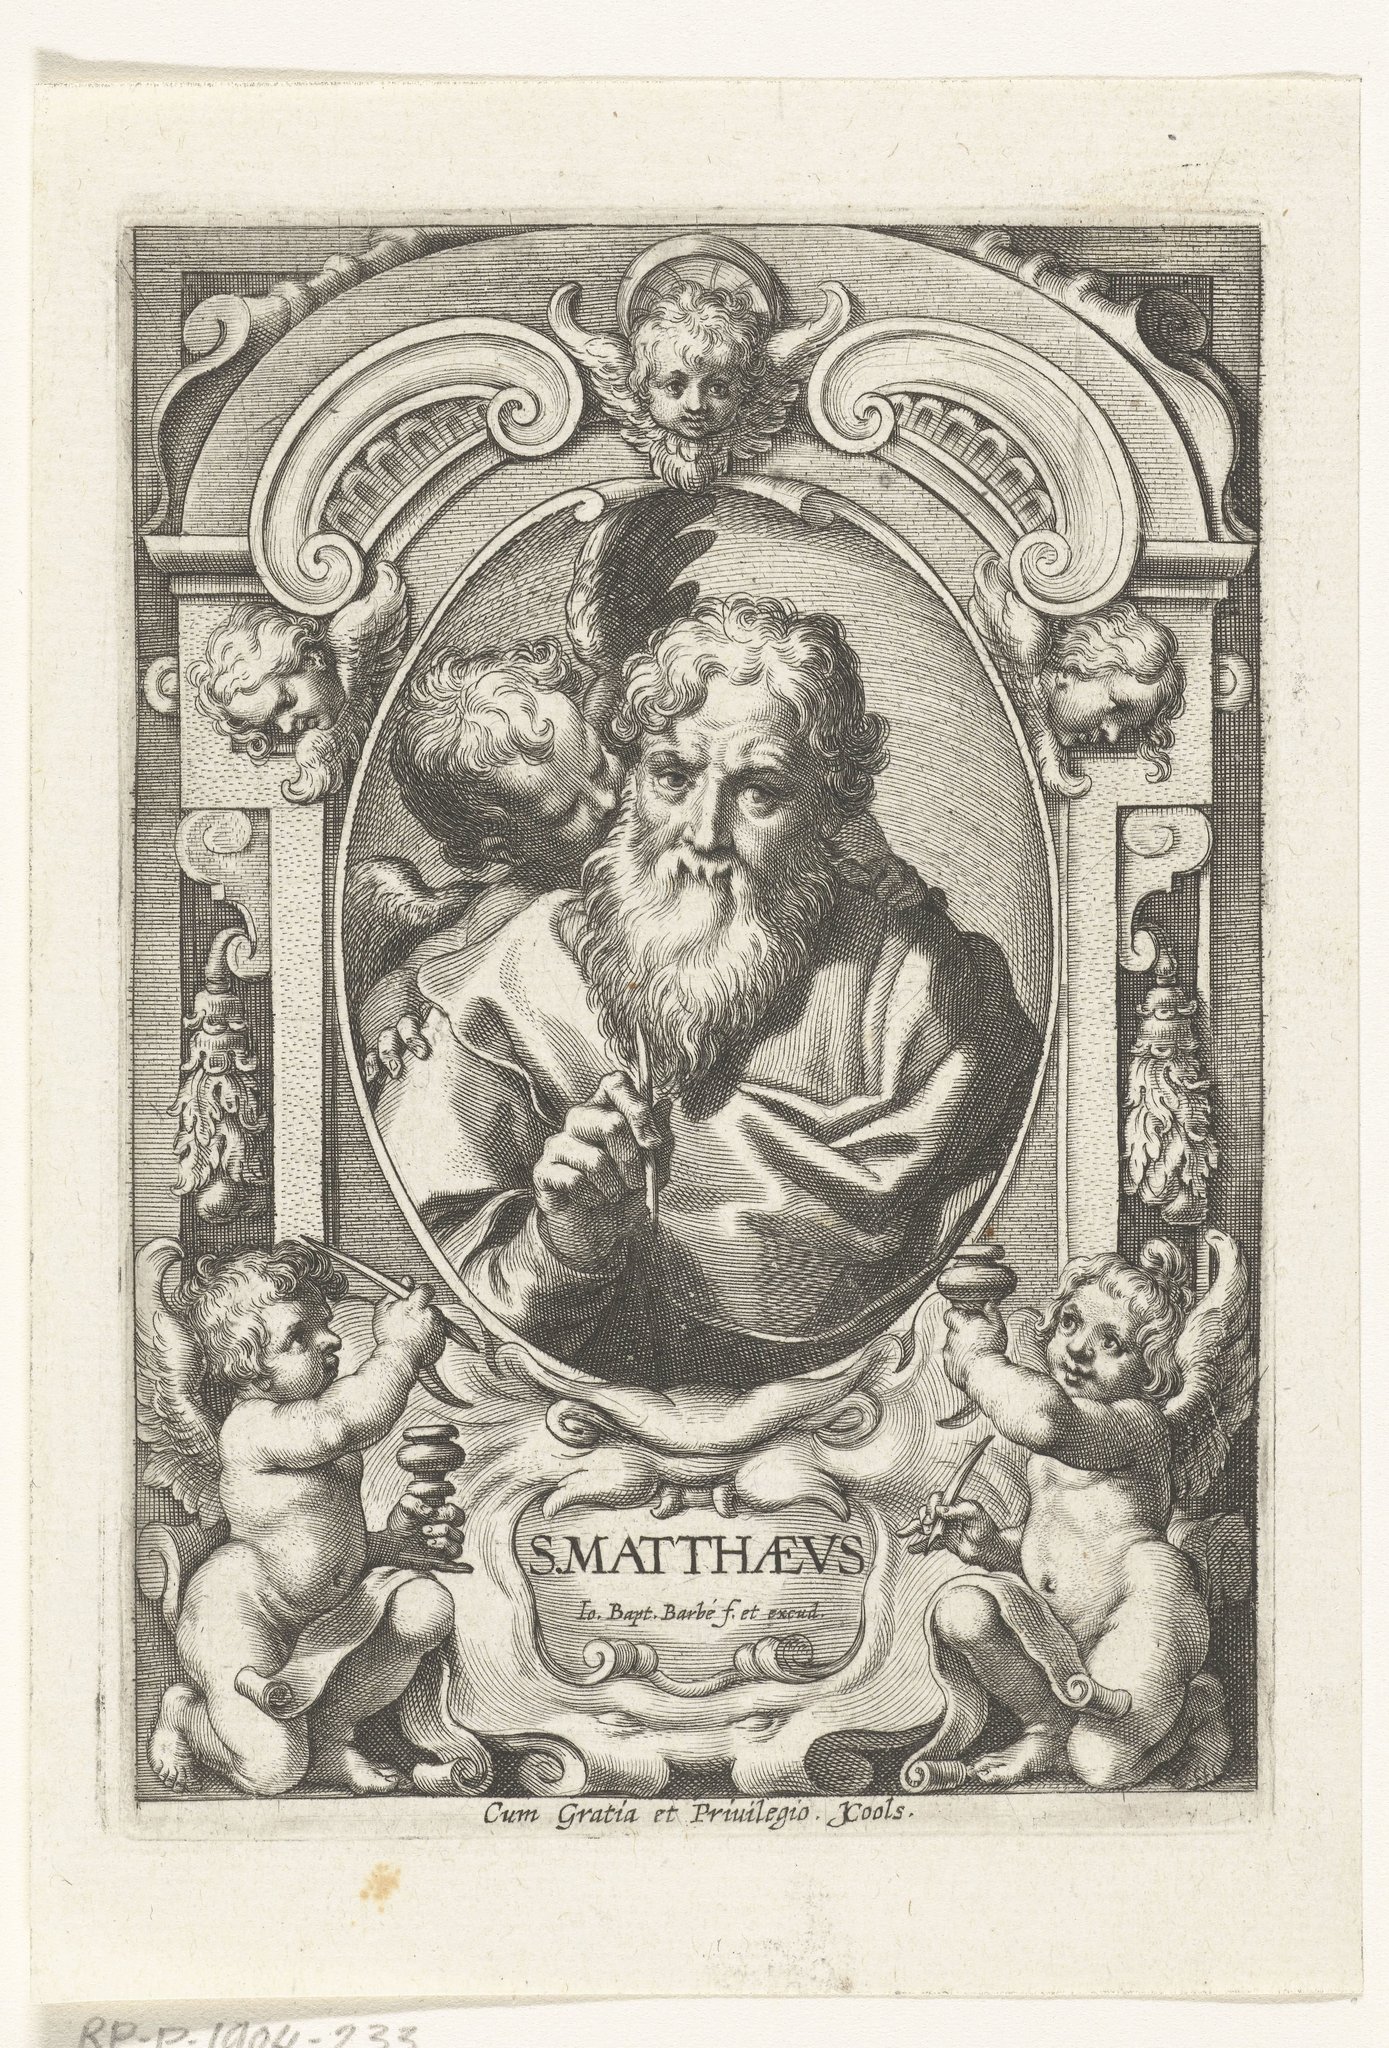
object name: print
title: S. Matthaevs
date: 1588-1648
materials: paper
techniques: engraving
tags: the apostle and evangelist matthew (mattheus); possible attributes: angel, axe, book, halberd, pen and inkhorn, purse, scroll, square, sword, ornament derived from architectural details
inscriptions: collector's mark: Lugt 2228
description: Prent uit: SS. Apostolorum et Evangelistorum Icones, Jean Baptiste Barbé (uitgever). Prent naar tekening van Nicolaas van der Horst.